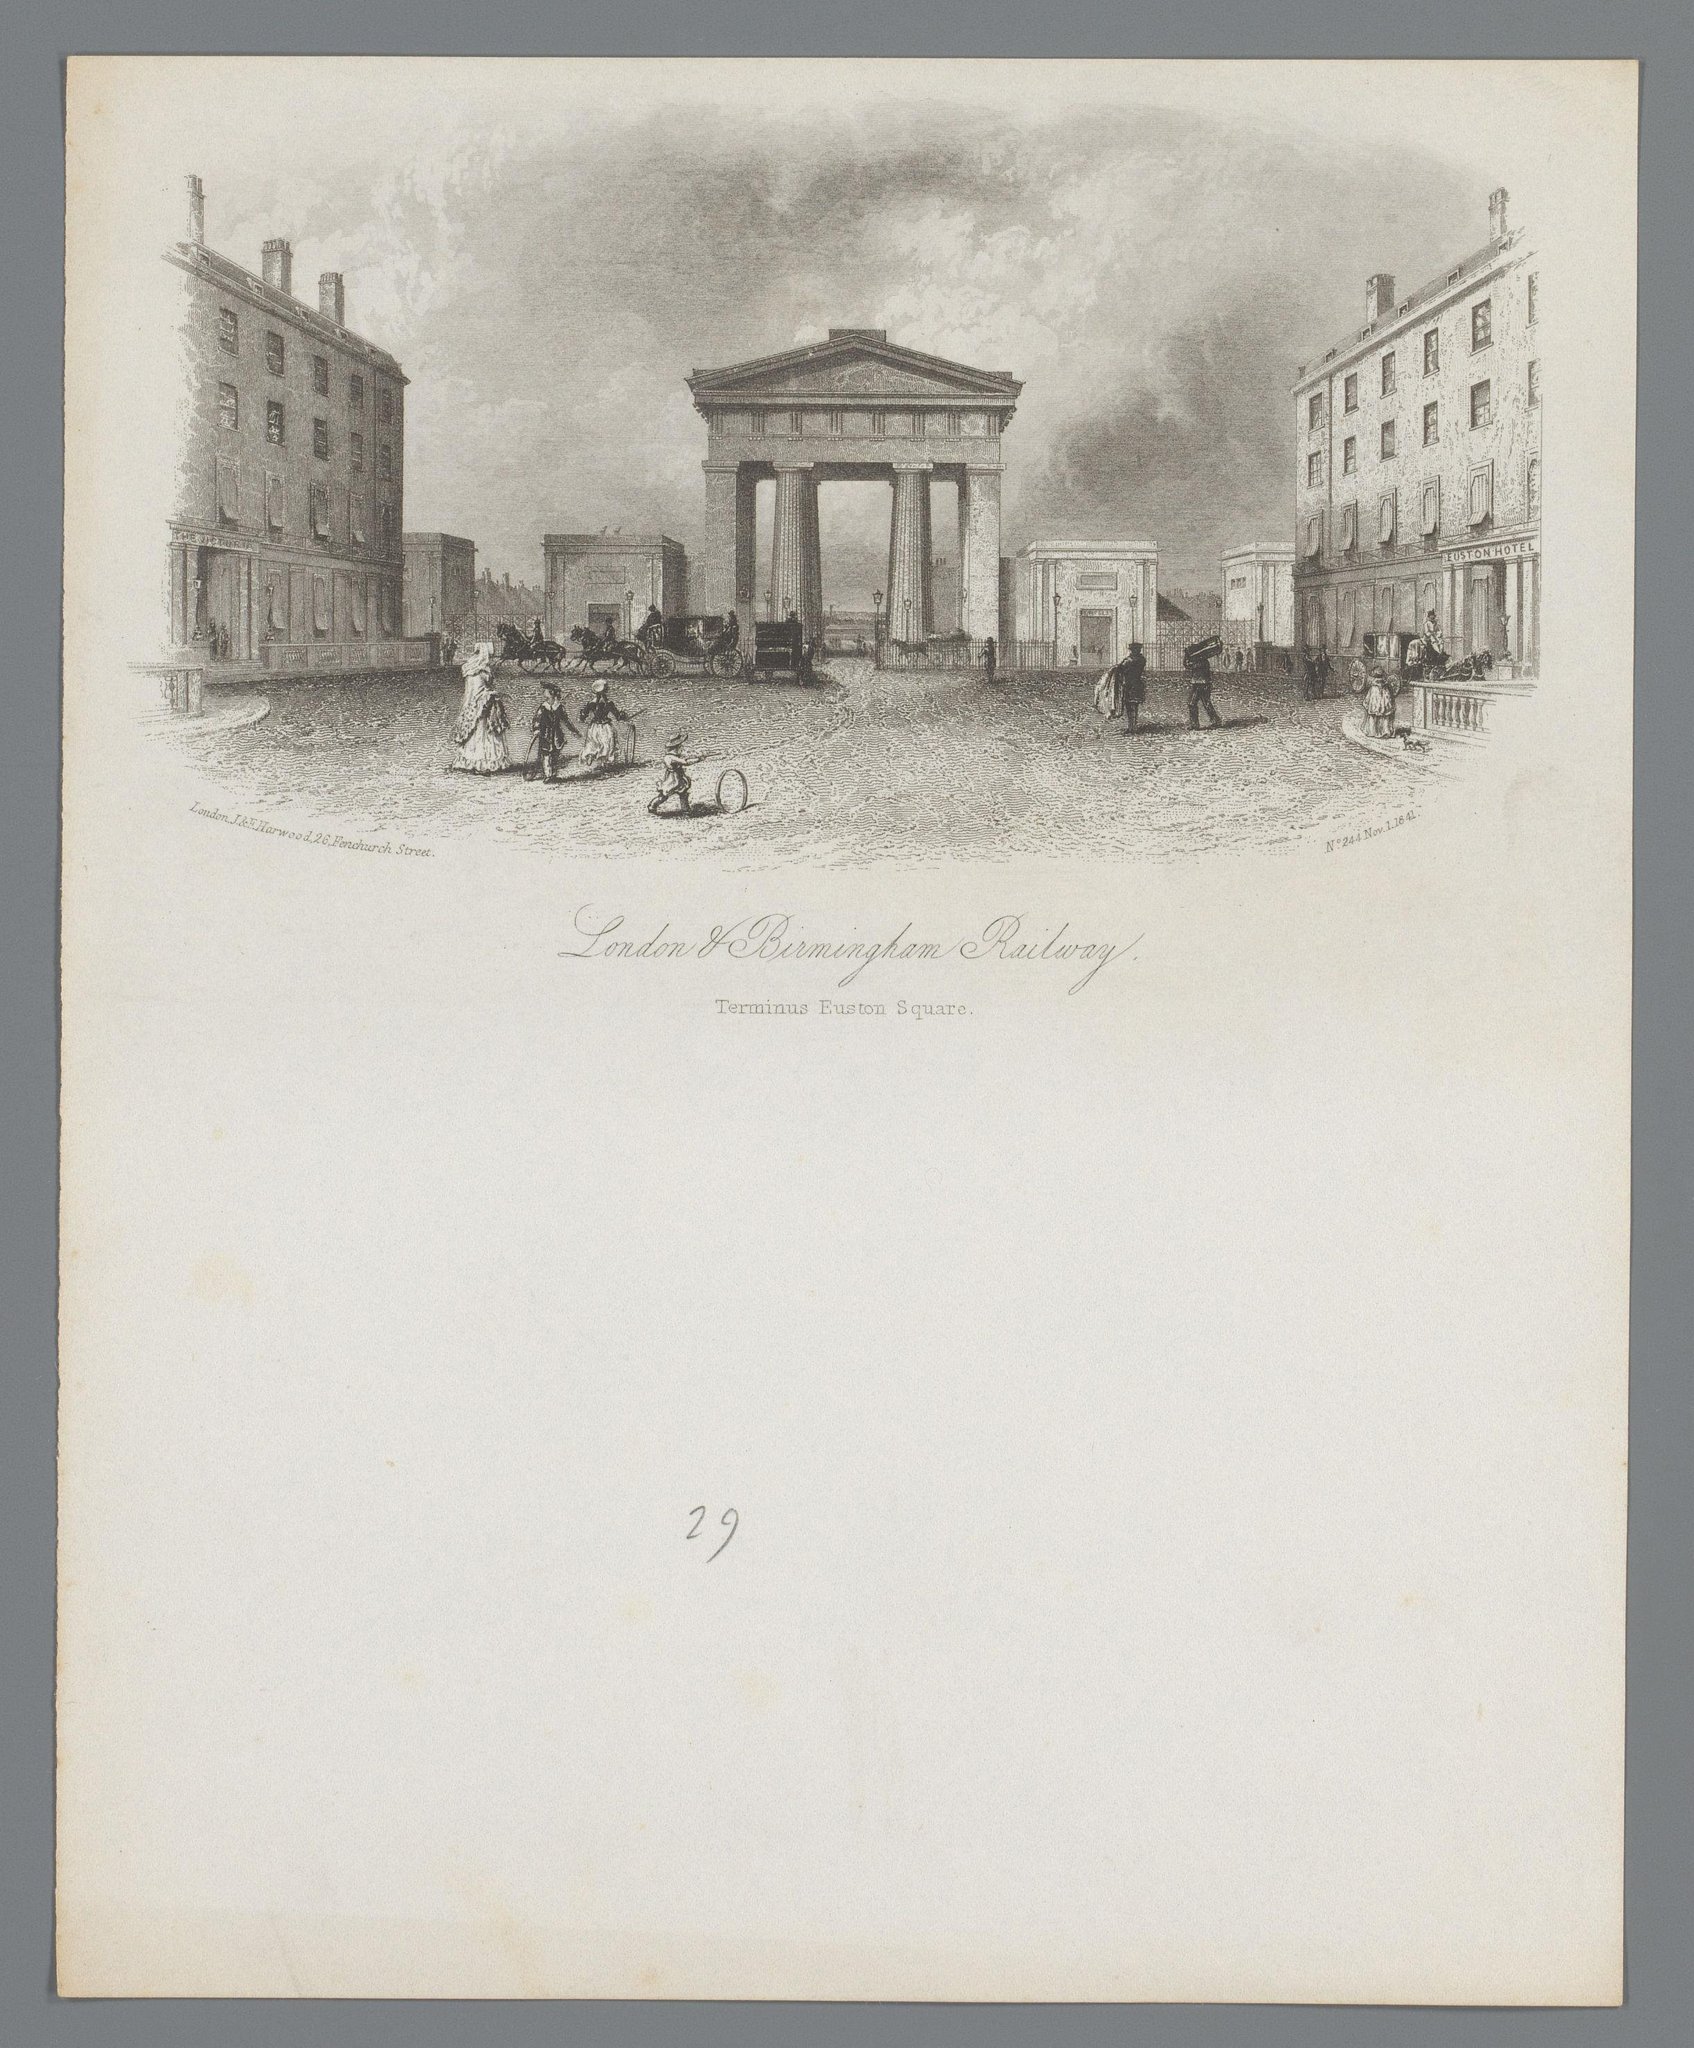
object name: stationery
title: Briefpapier met voorstelling van het eindpunt van de London & Birmingham Railway op Euston Square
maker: Anonymous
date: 1841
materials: paper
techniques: engraving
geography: london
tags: square, place, circus, etc., four-wheeled, animal-drawn vehicle, e.g.: cab, carriage, coach, railway, train